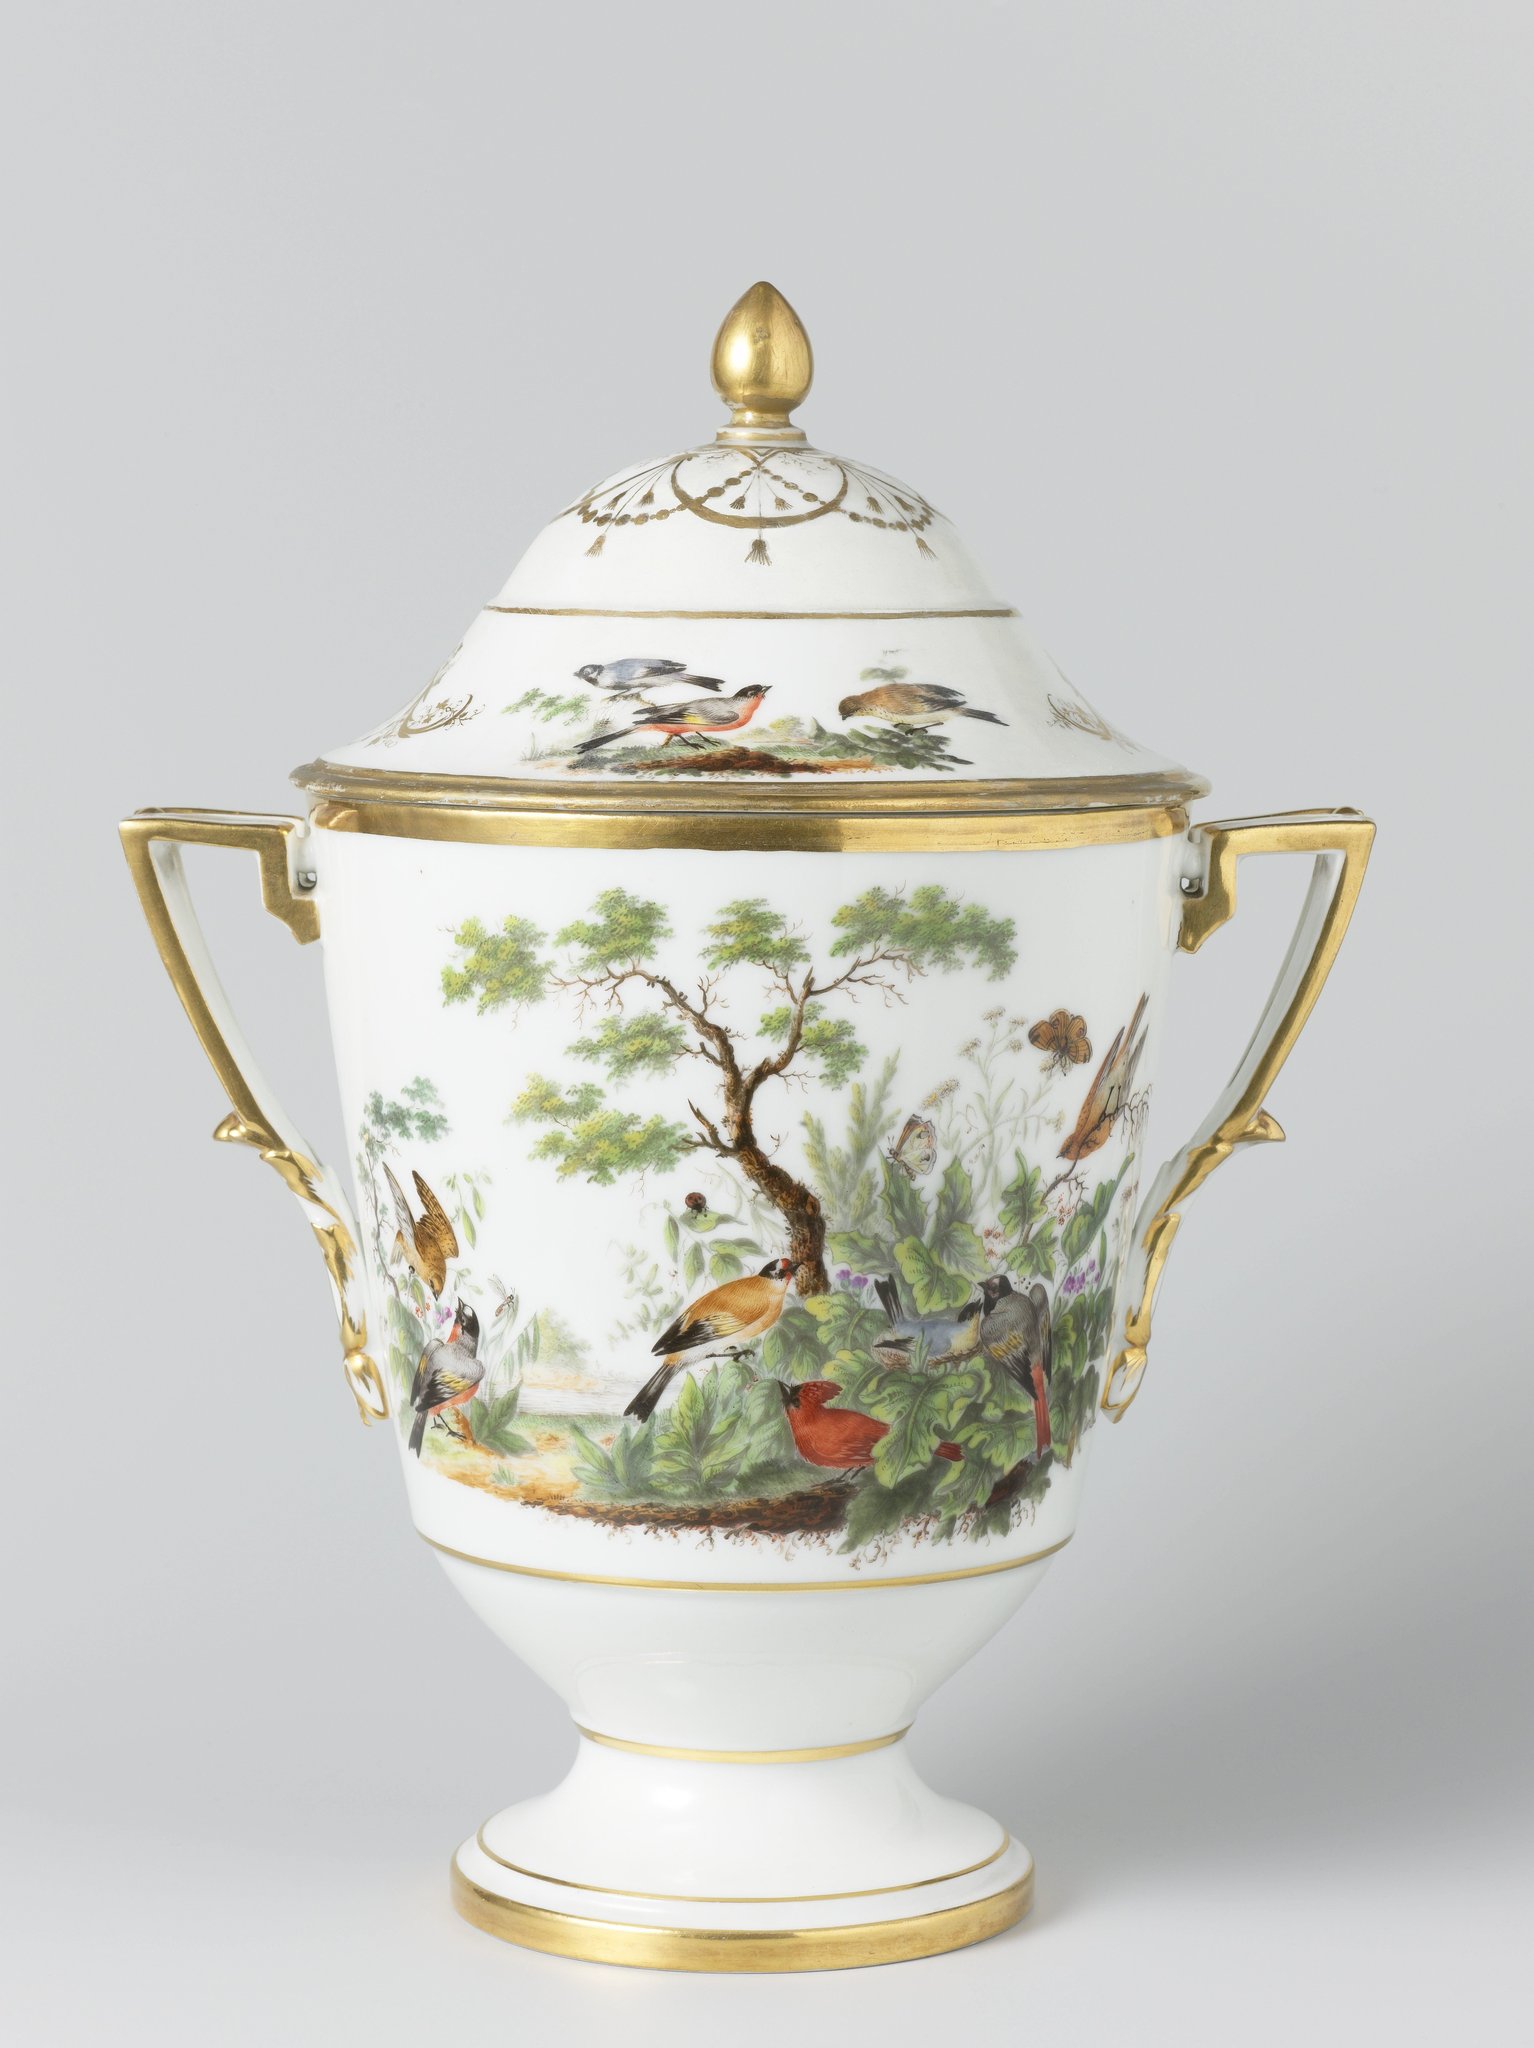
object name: vase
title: Pair of vases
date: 1809-1814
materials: porcelain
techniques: painted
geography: nieuwer-amstel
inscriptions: factory mark: ‘Amstel’, factory mark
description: In 1810 Dommer father and son moved their porcelain factory from Ouder-Amstel to the grounds of a chemical factory in Nieuwer-Amstel, near the Pijp district of present-day Amsterdam. Porcelain was probably no longer actually produced in this factory, but only decorated there. These vases were bought from a porcelain factory in Paris and subsequently decorated in Nieuwer-Amstel with birds, trees and fruit.